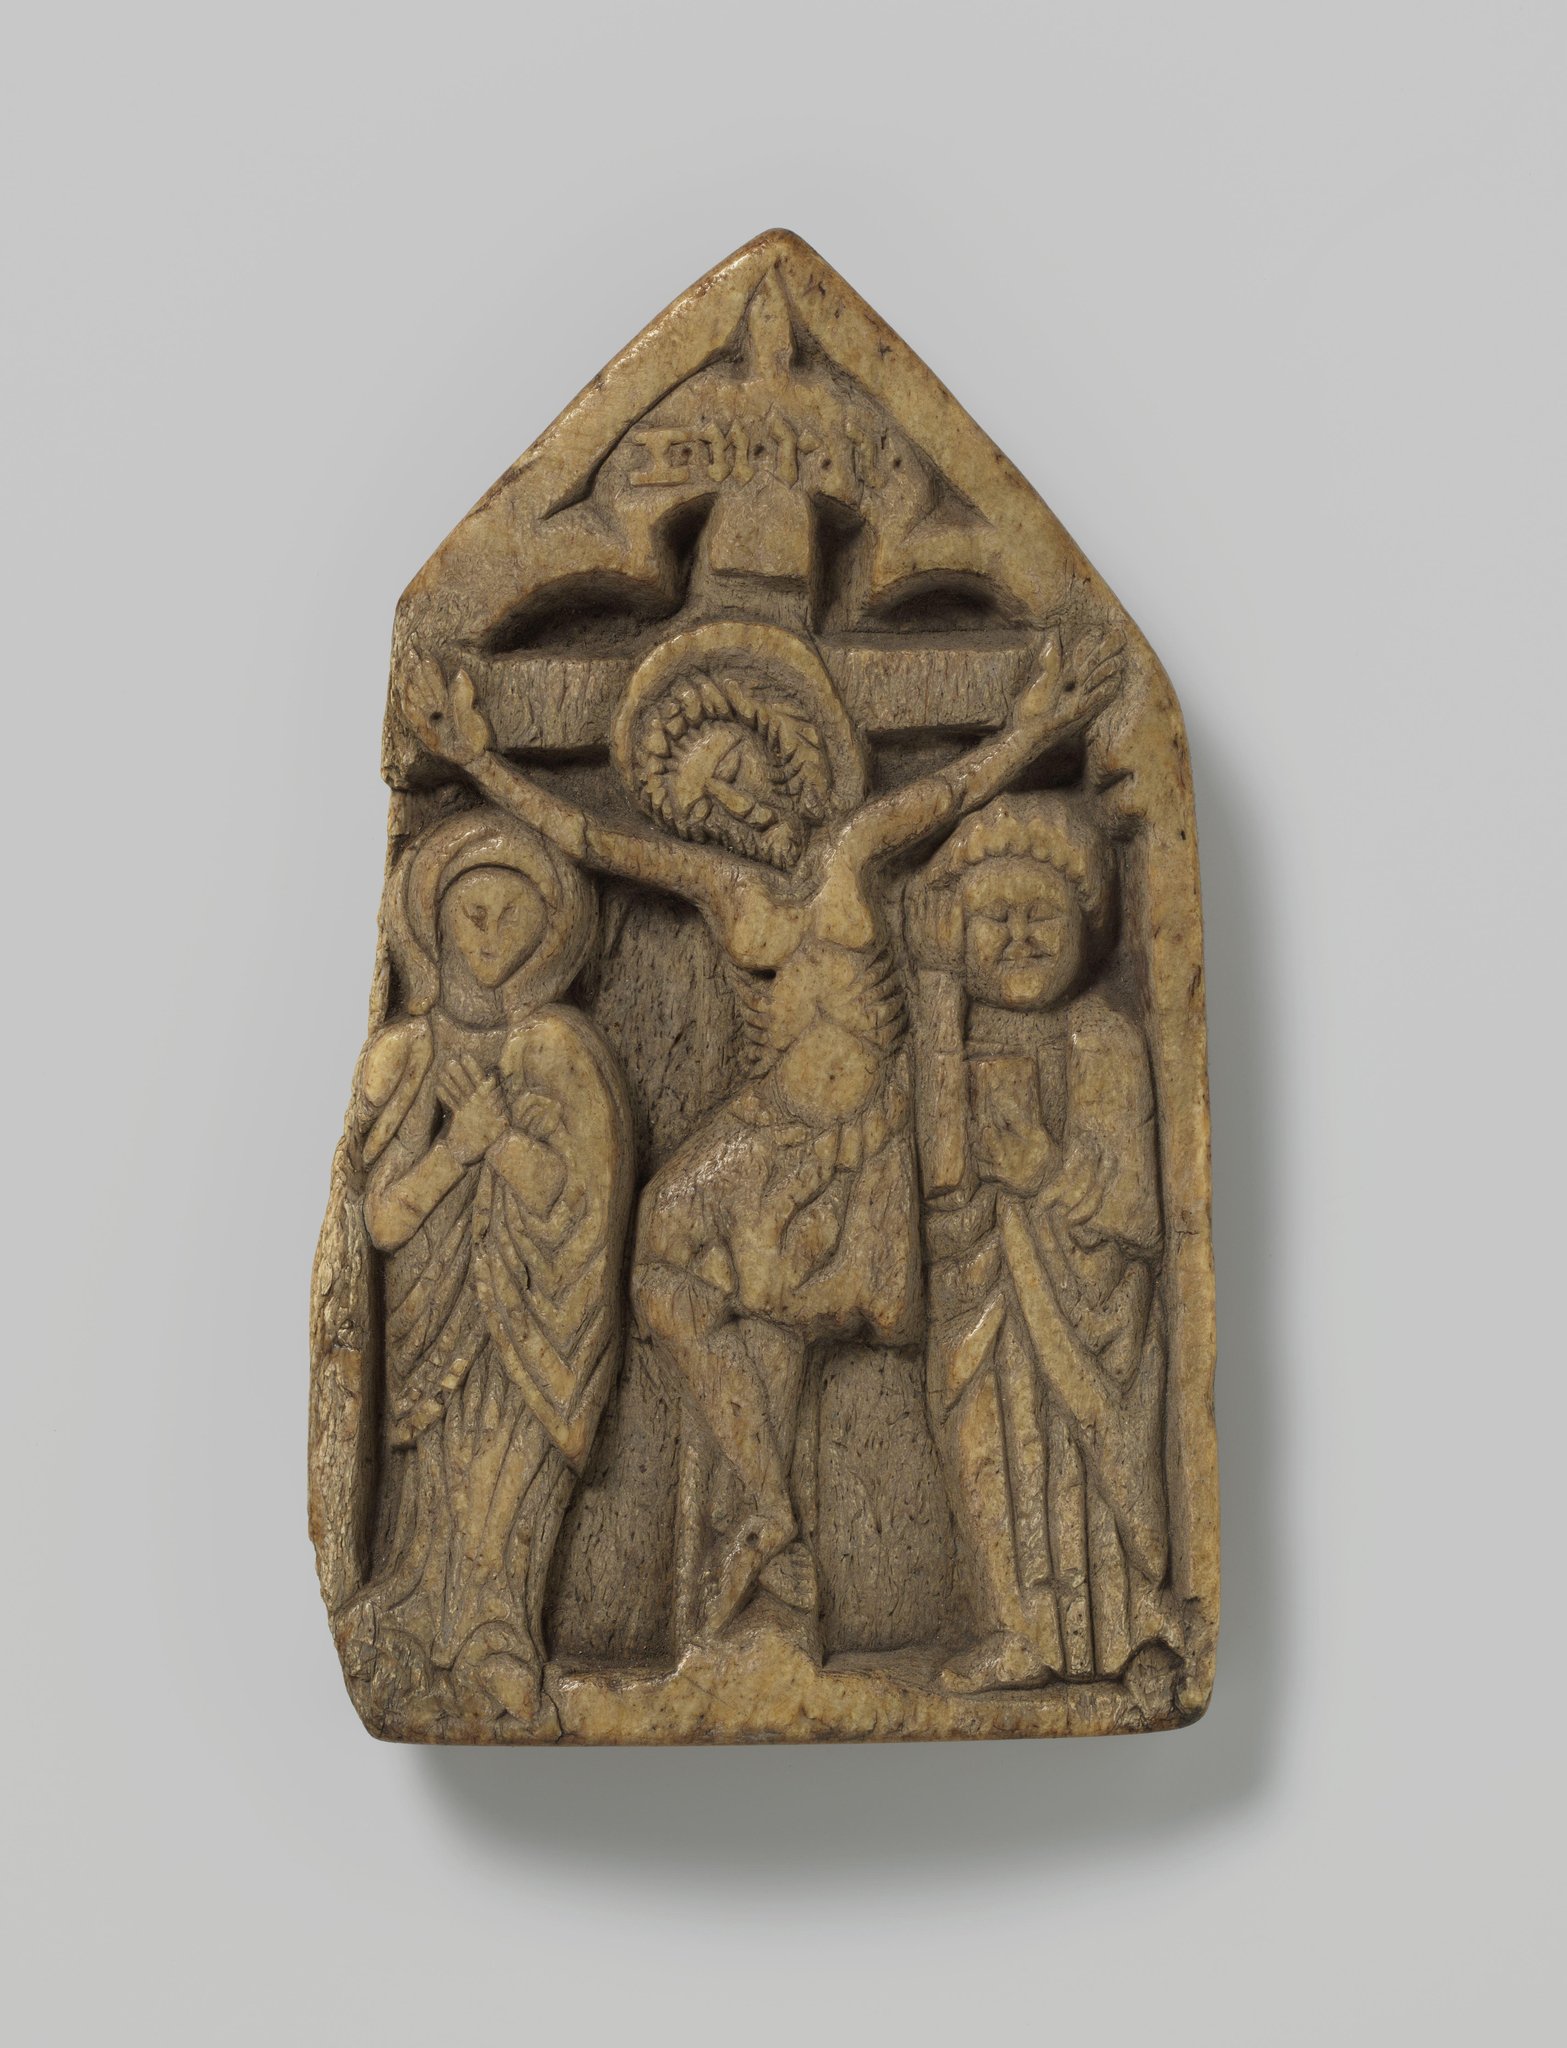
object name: relief sculpture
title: Relief met Bijbelse voorstelling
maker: Anonymous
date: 1400-1500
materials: bone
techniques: cutting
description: Basrelief van been. Van boven driekantig verder vierkant. Voorstellende Christus aan het kruis tussen Maria en Johannes.